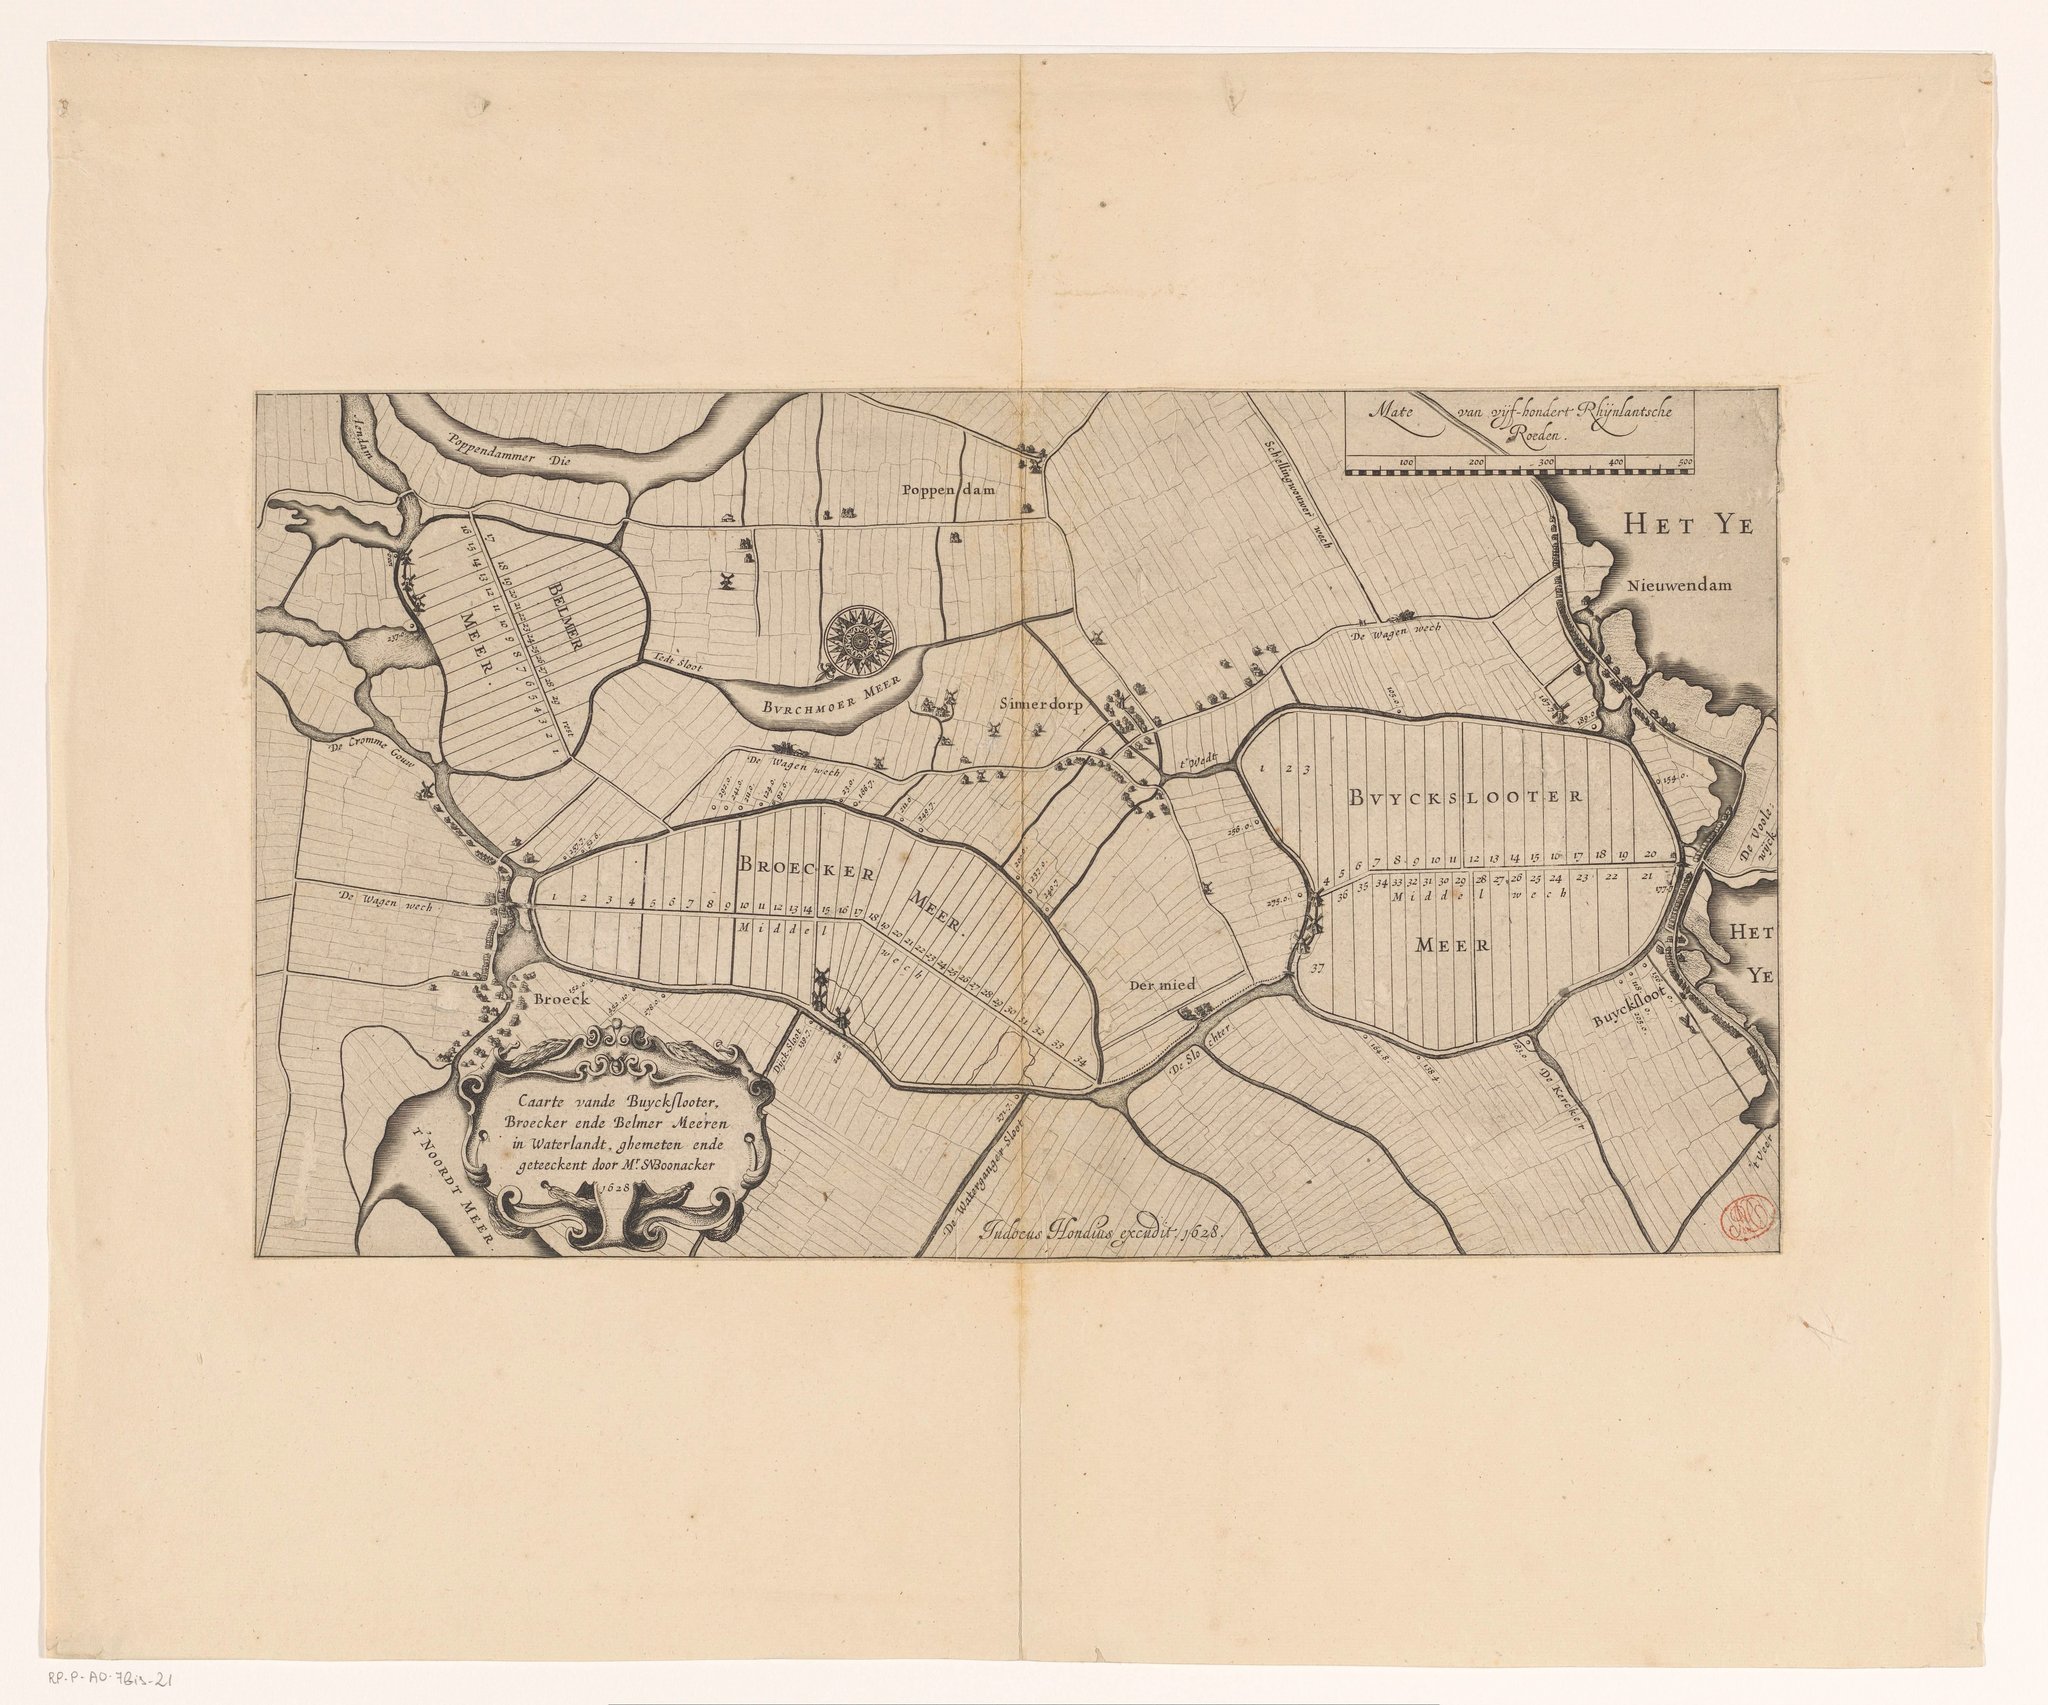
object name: print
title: Kaart van de Buiksloter-, Broeker- en Belmermeerpolder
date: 1628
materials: paper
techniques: engraving, etching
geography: amsterdam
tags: maps of separate countries or regions, polder, reclaimed land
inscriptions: collector's mark: Lugt 195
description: Het Buiksloter-, Broeker- en Belmermeer werden in 1627 drooggelegd. Linksonder de titelcartouche. Rechtsboven een schaalstok: Mate van vijf-hondert Rhijnlantsche roeden.